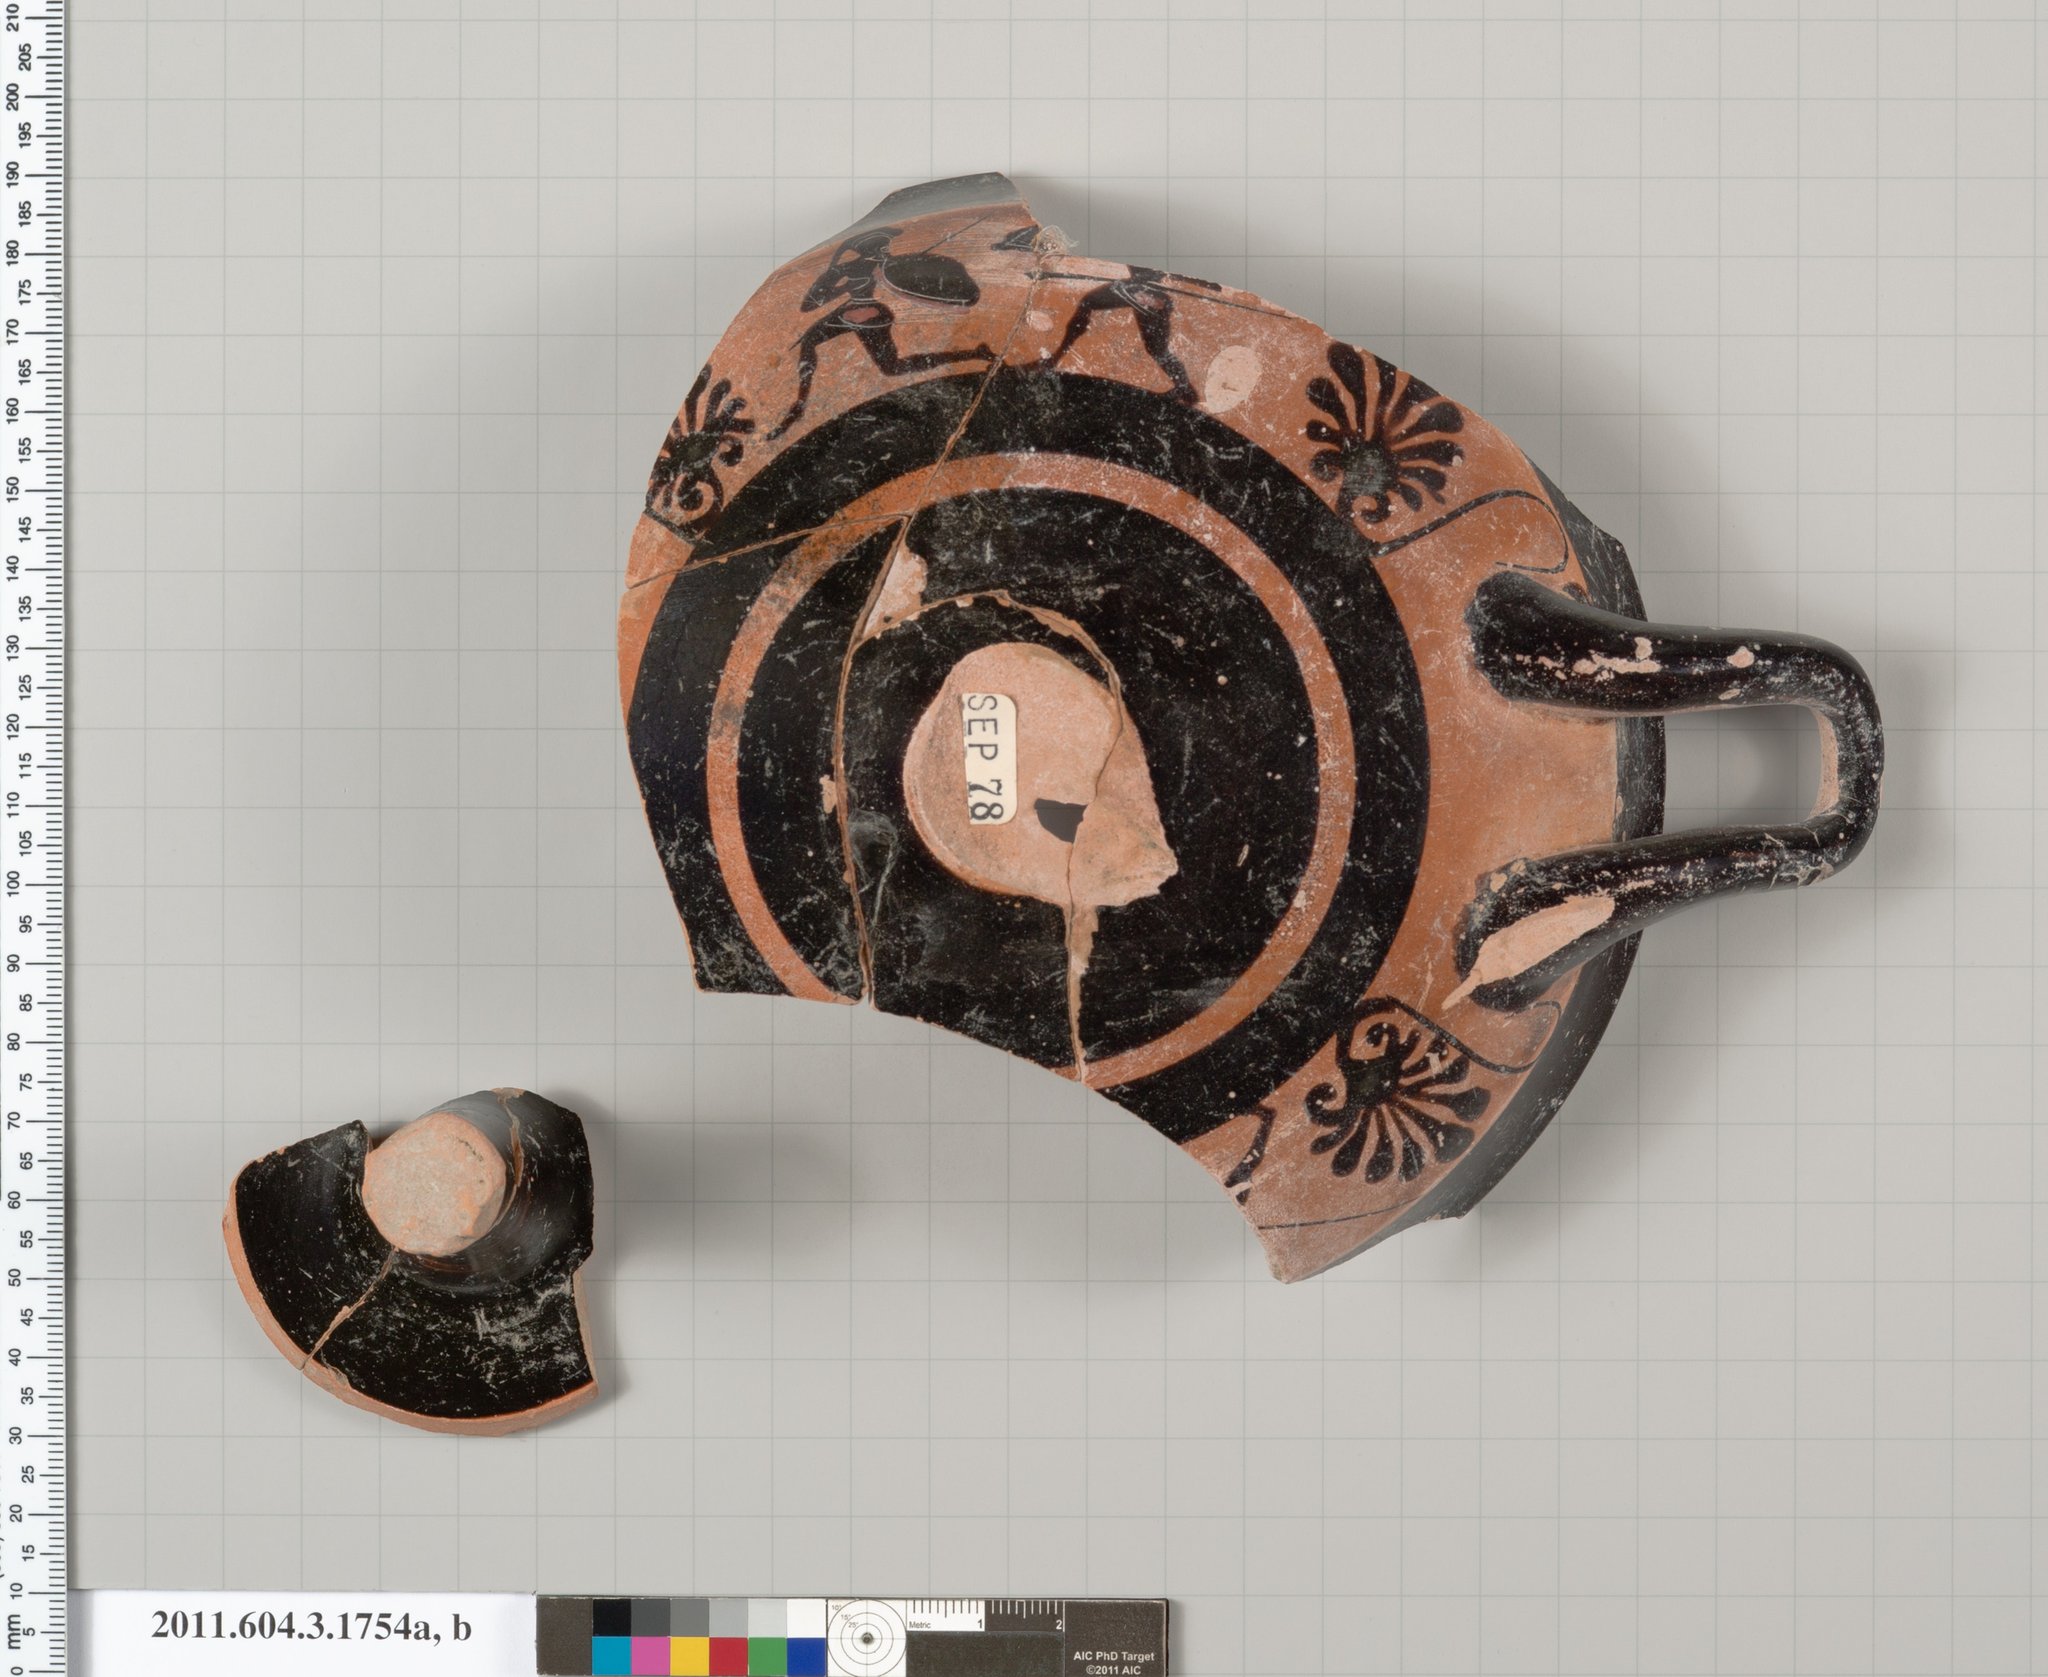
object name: kylix fragment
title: Terracotta fragments of a kylix: Band cup (drinking cup)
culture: greek, attic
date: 550-526 BCE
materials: terracotta